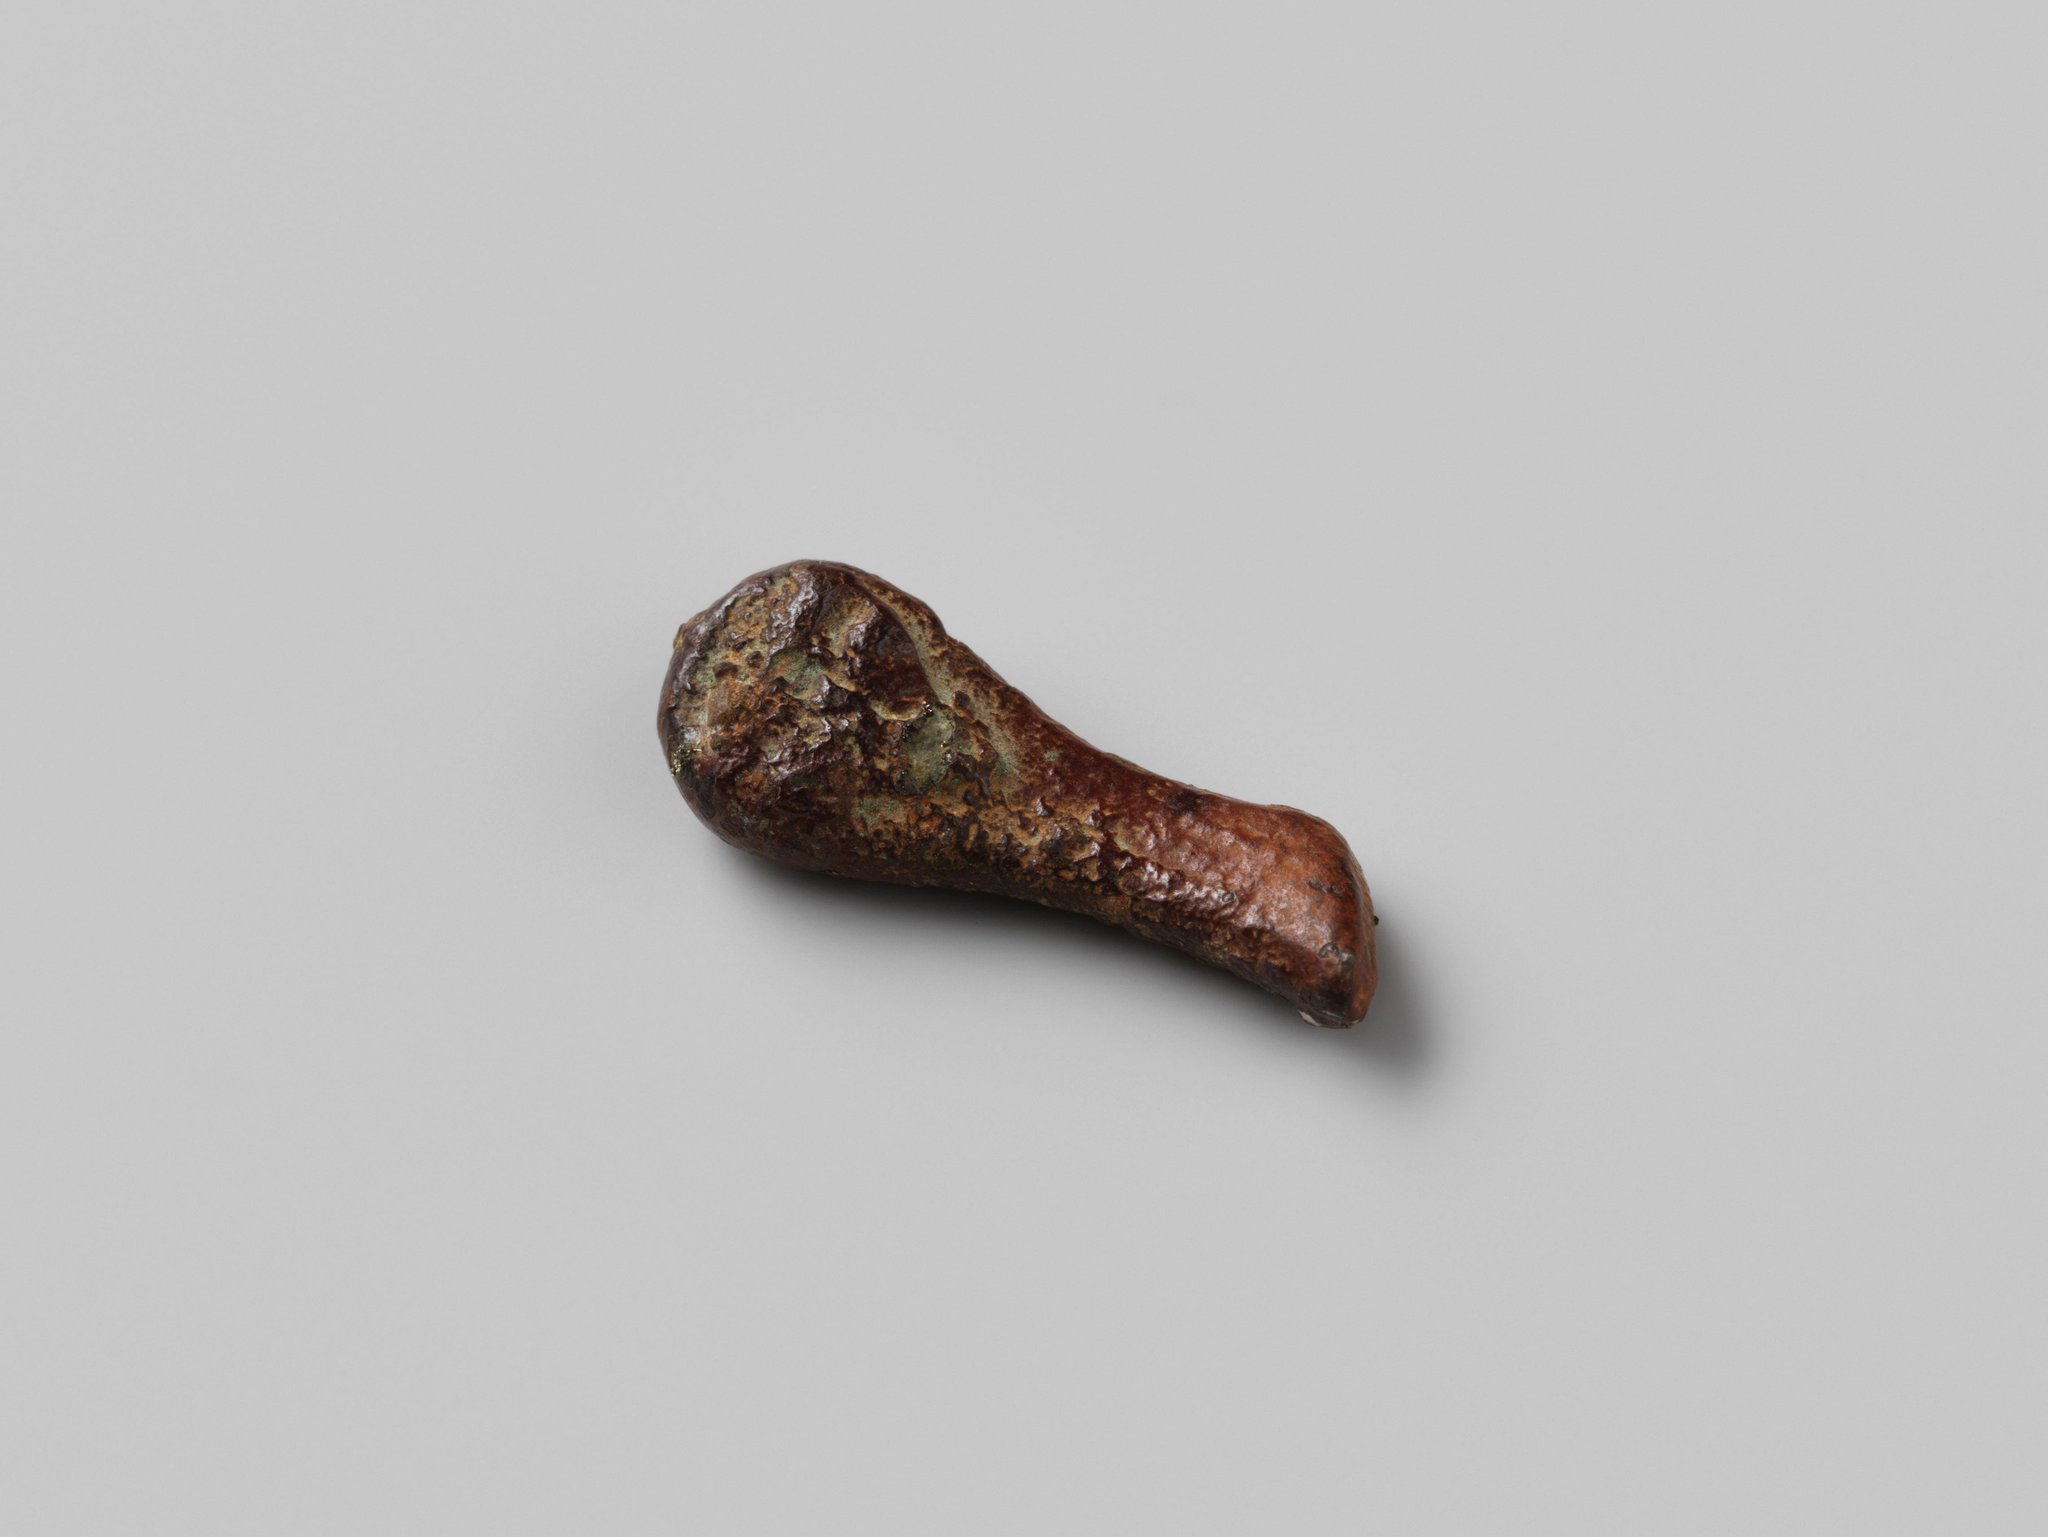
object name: bekroning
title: Bekroning of uiteinde uit het wrak van de Oost-Indiëvaarder Hollandia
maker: Anonymous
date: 1700-1743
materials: copper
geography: netherlands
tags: verenigde oostindische compagnie, hollandia (schip), annet